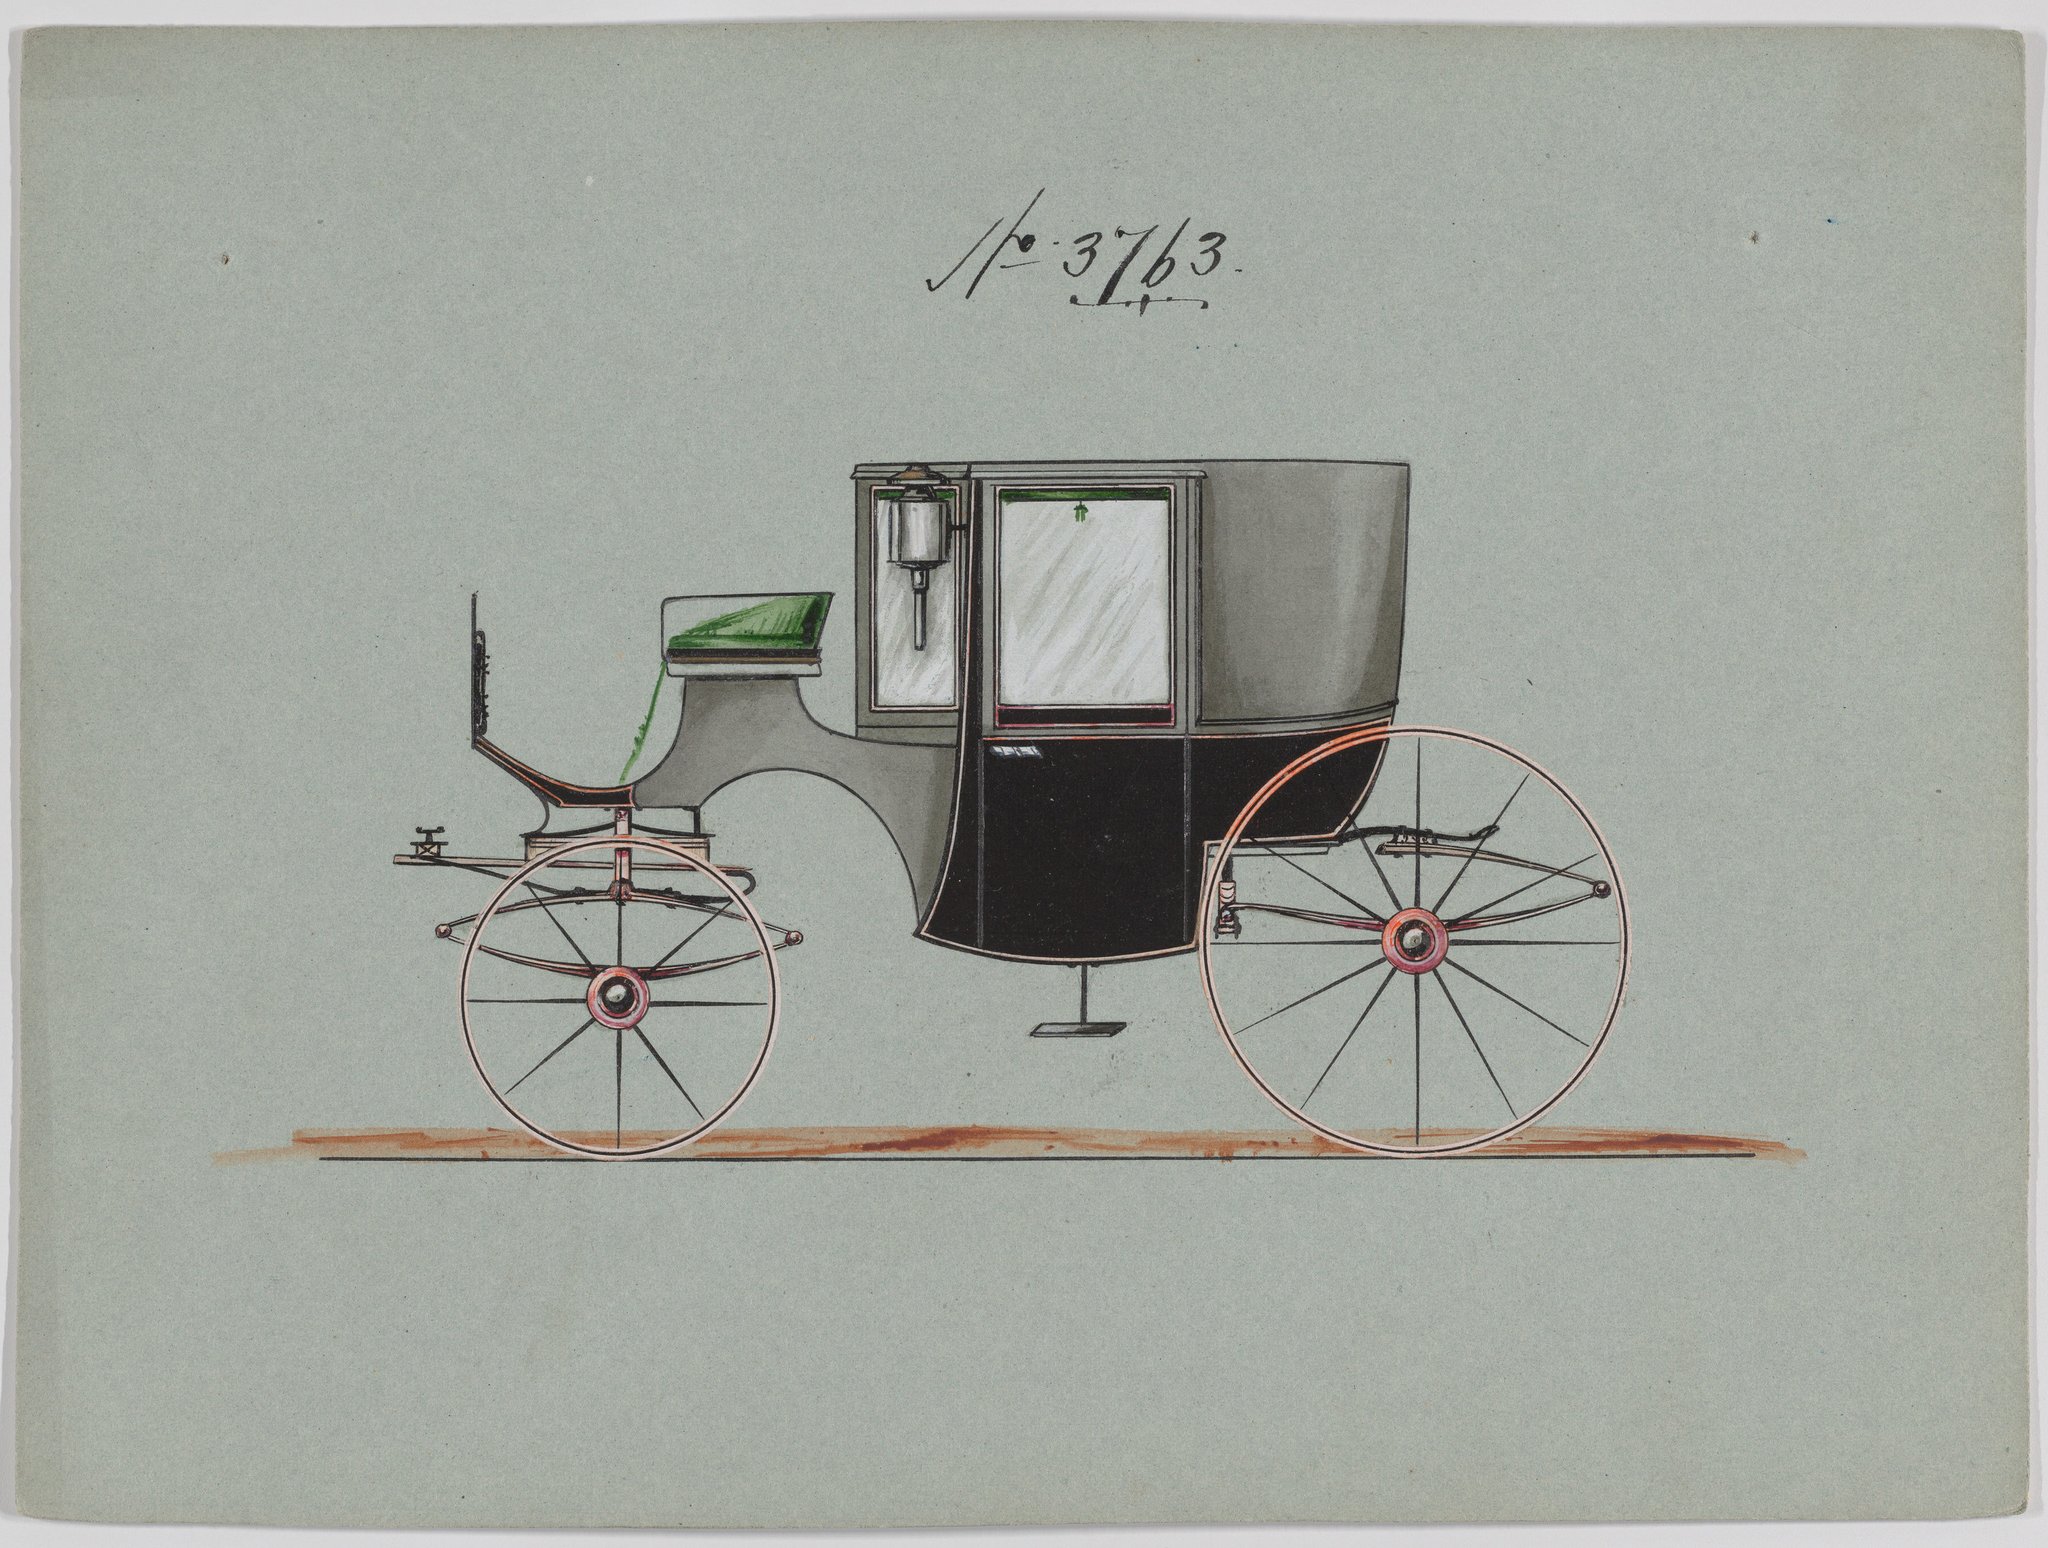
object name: drawing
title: Design for Coupé, no. 3763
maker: brewster & co.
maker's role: manufacturer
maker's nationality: american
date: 1882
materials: gouache, gum arabic, ink, watercolor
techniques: pen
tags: carriages